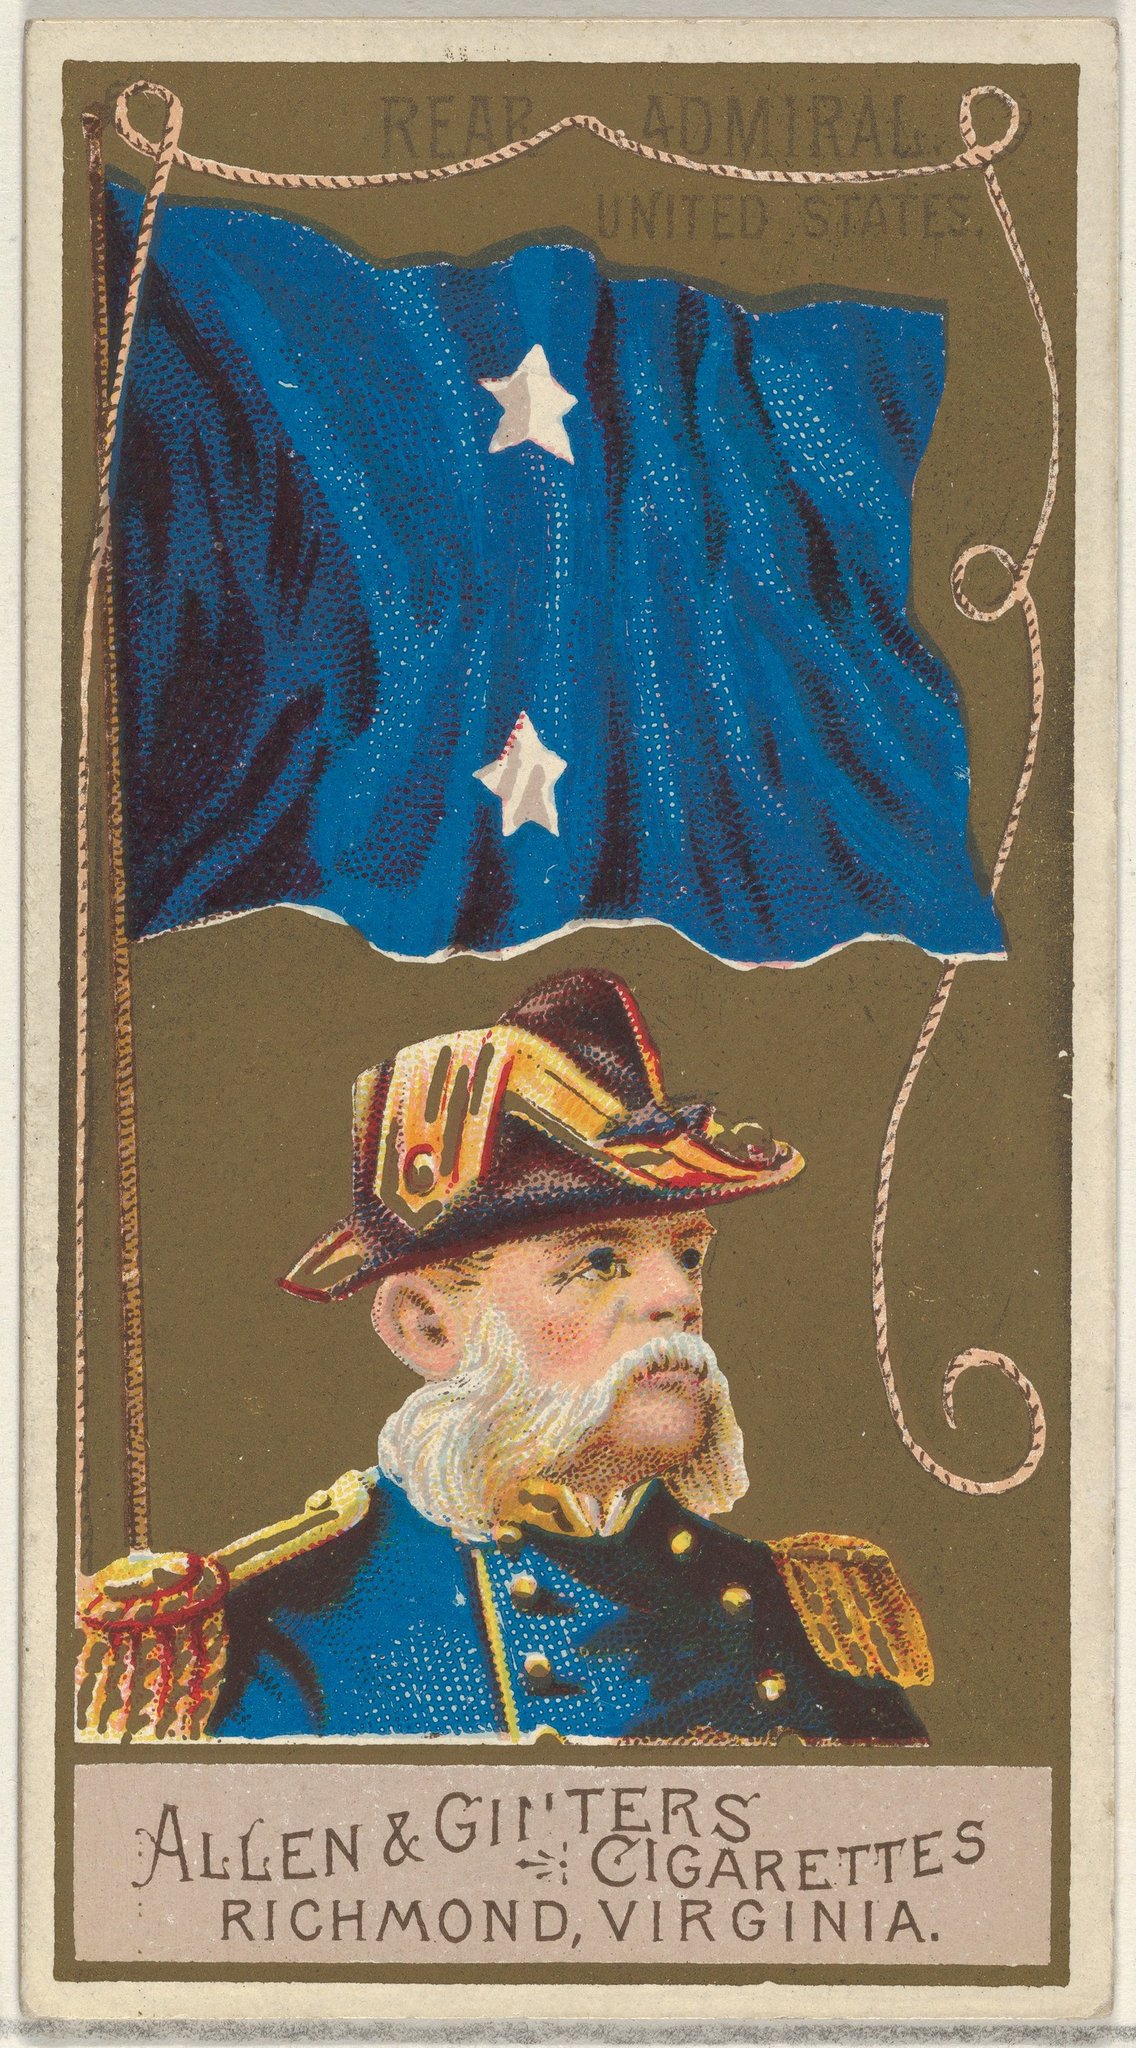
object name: print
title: Rear Admiral, United States, from the Naval Flags series (N17) for Allen & Ginter Cigarettes Brands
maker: allen & ginter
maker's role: publisher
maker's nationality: american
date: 1888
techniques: color lithograph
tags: men,flags